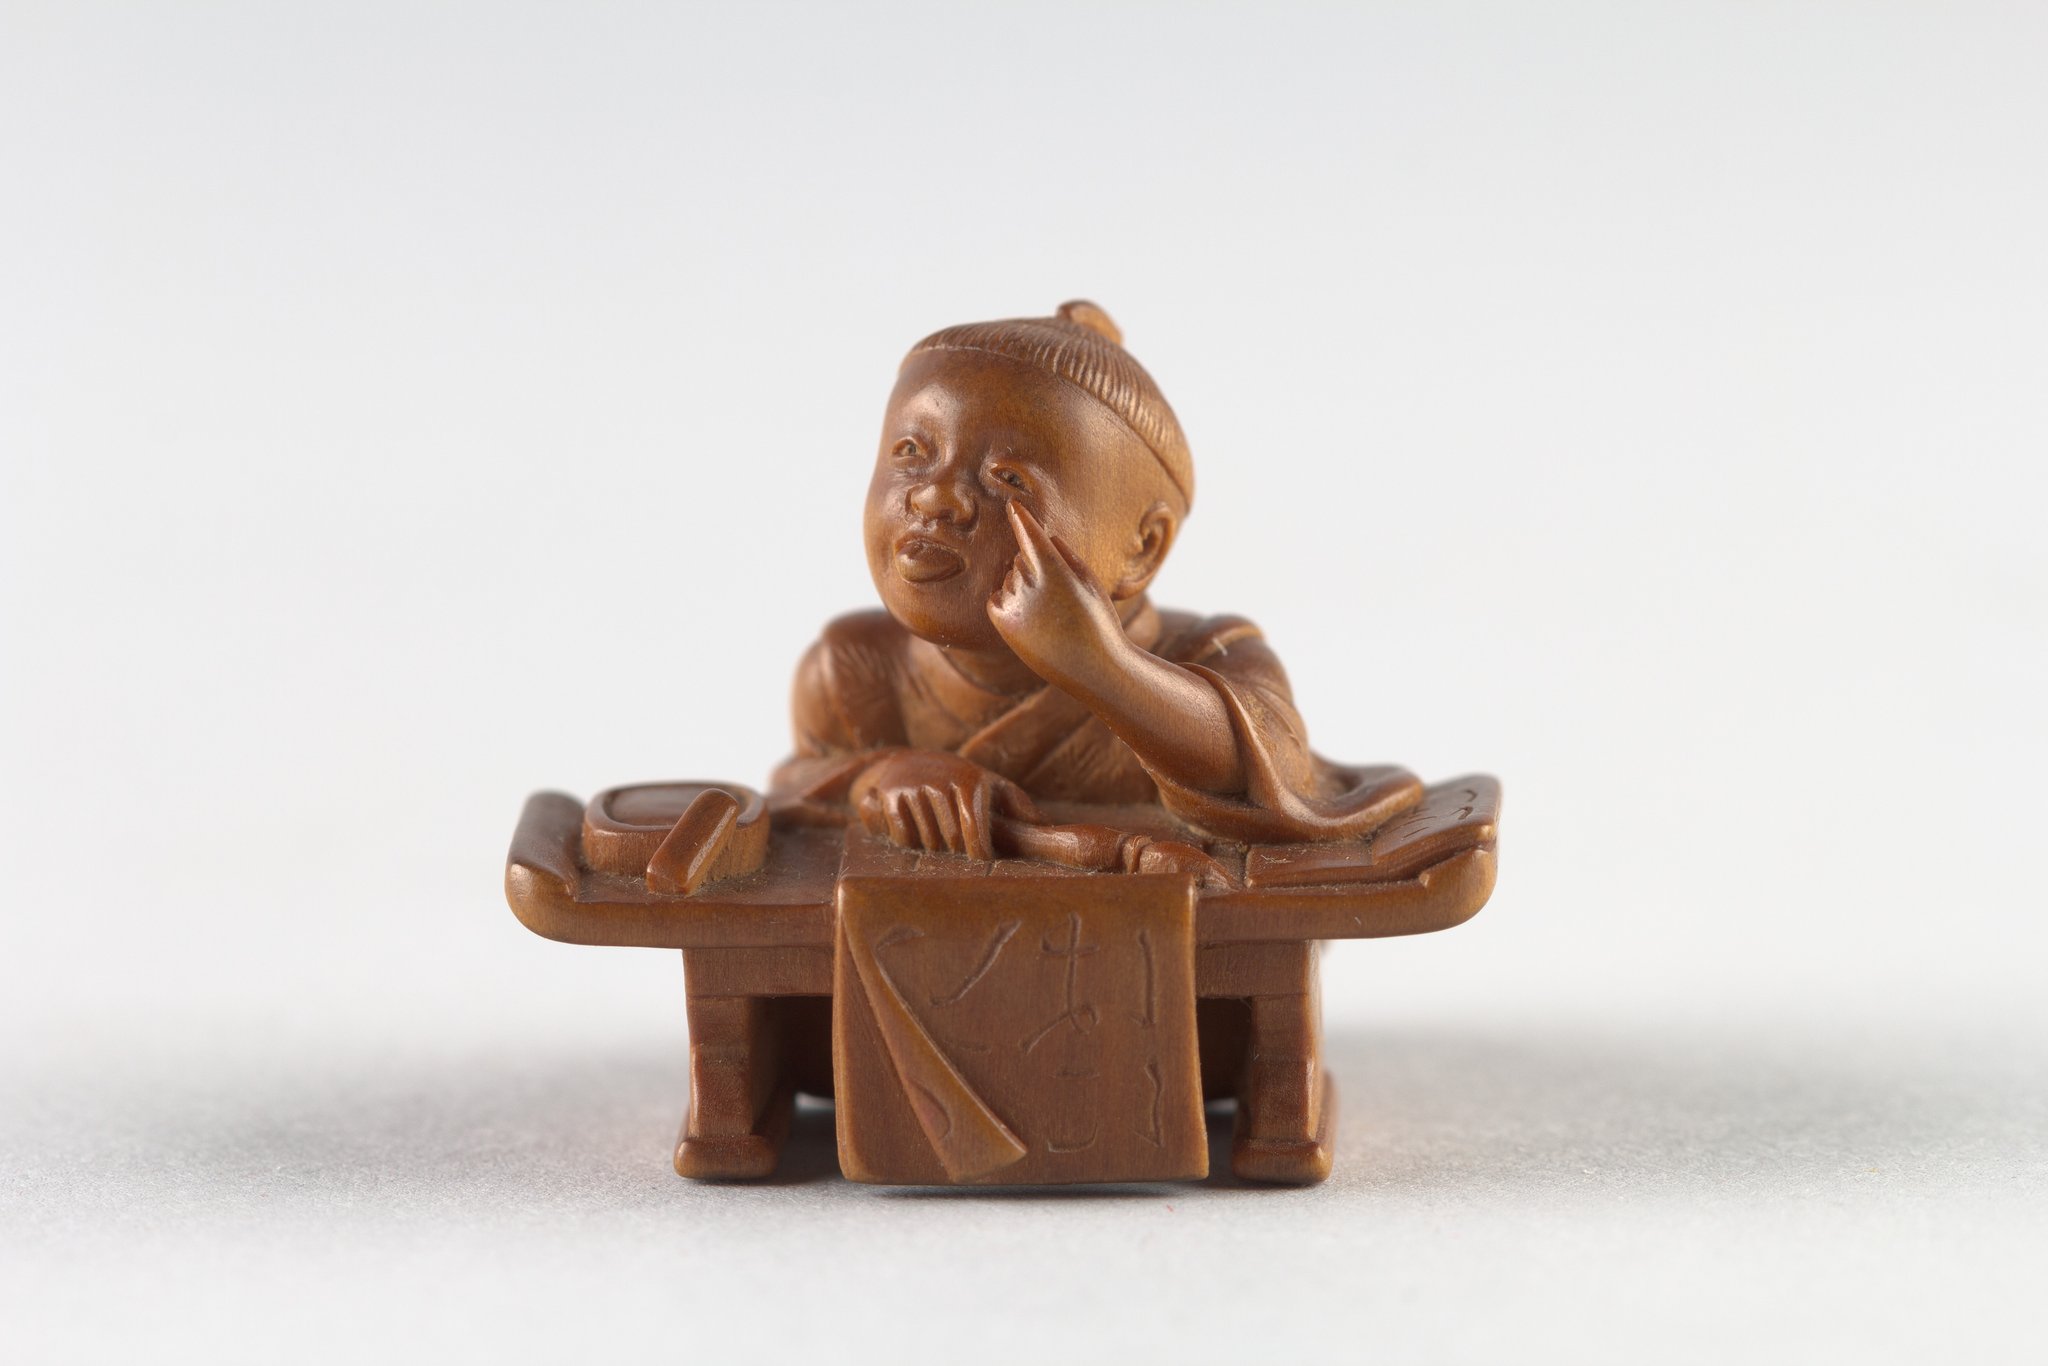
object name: netsuke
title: Netsuke of Boy Writing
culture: japanese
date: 1801-1900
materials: wood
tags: boys,writing